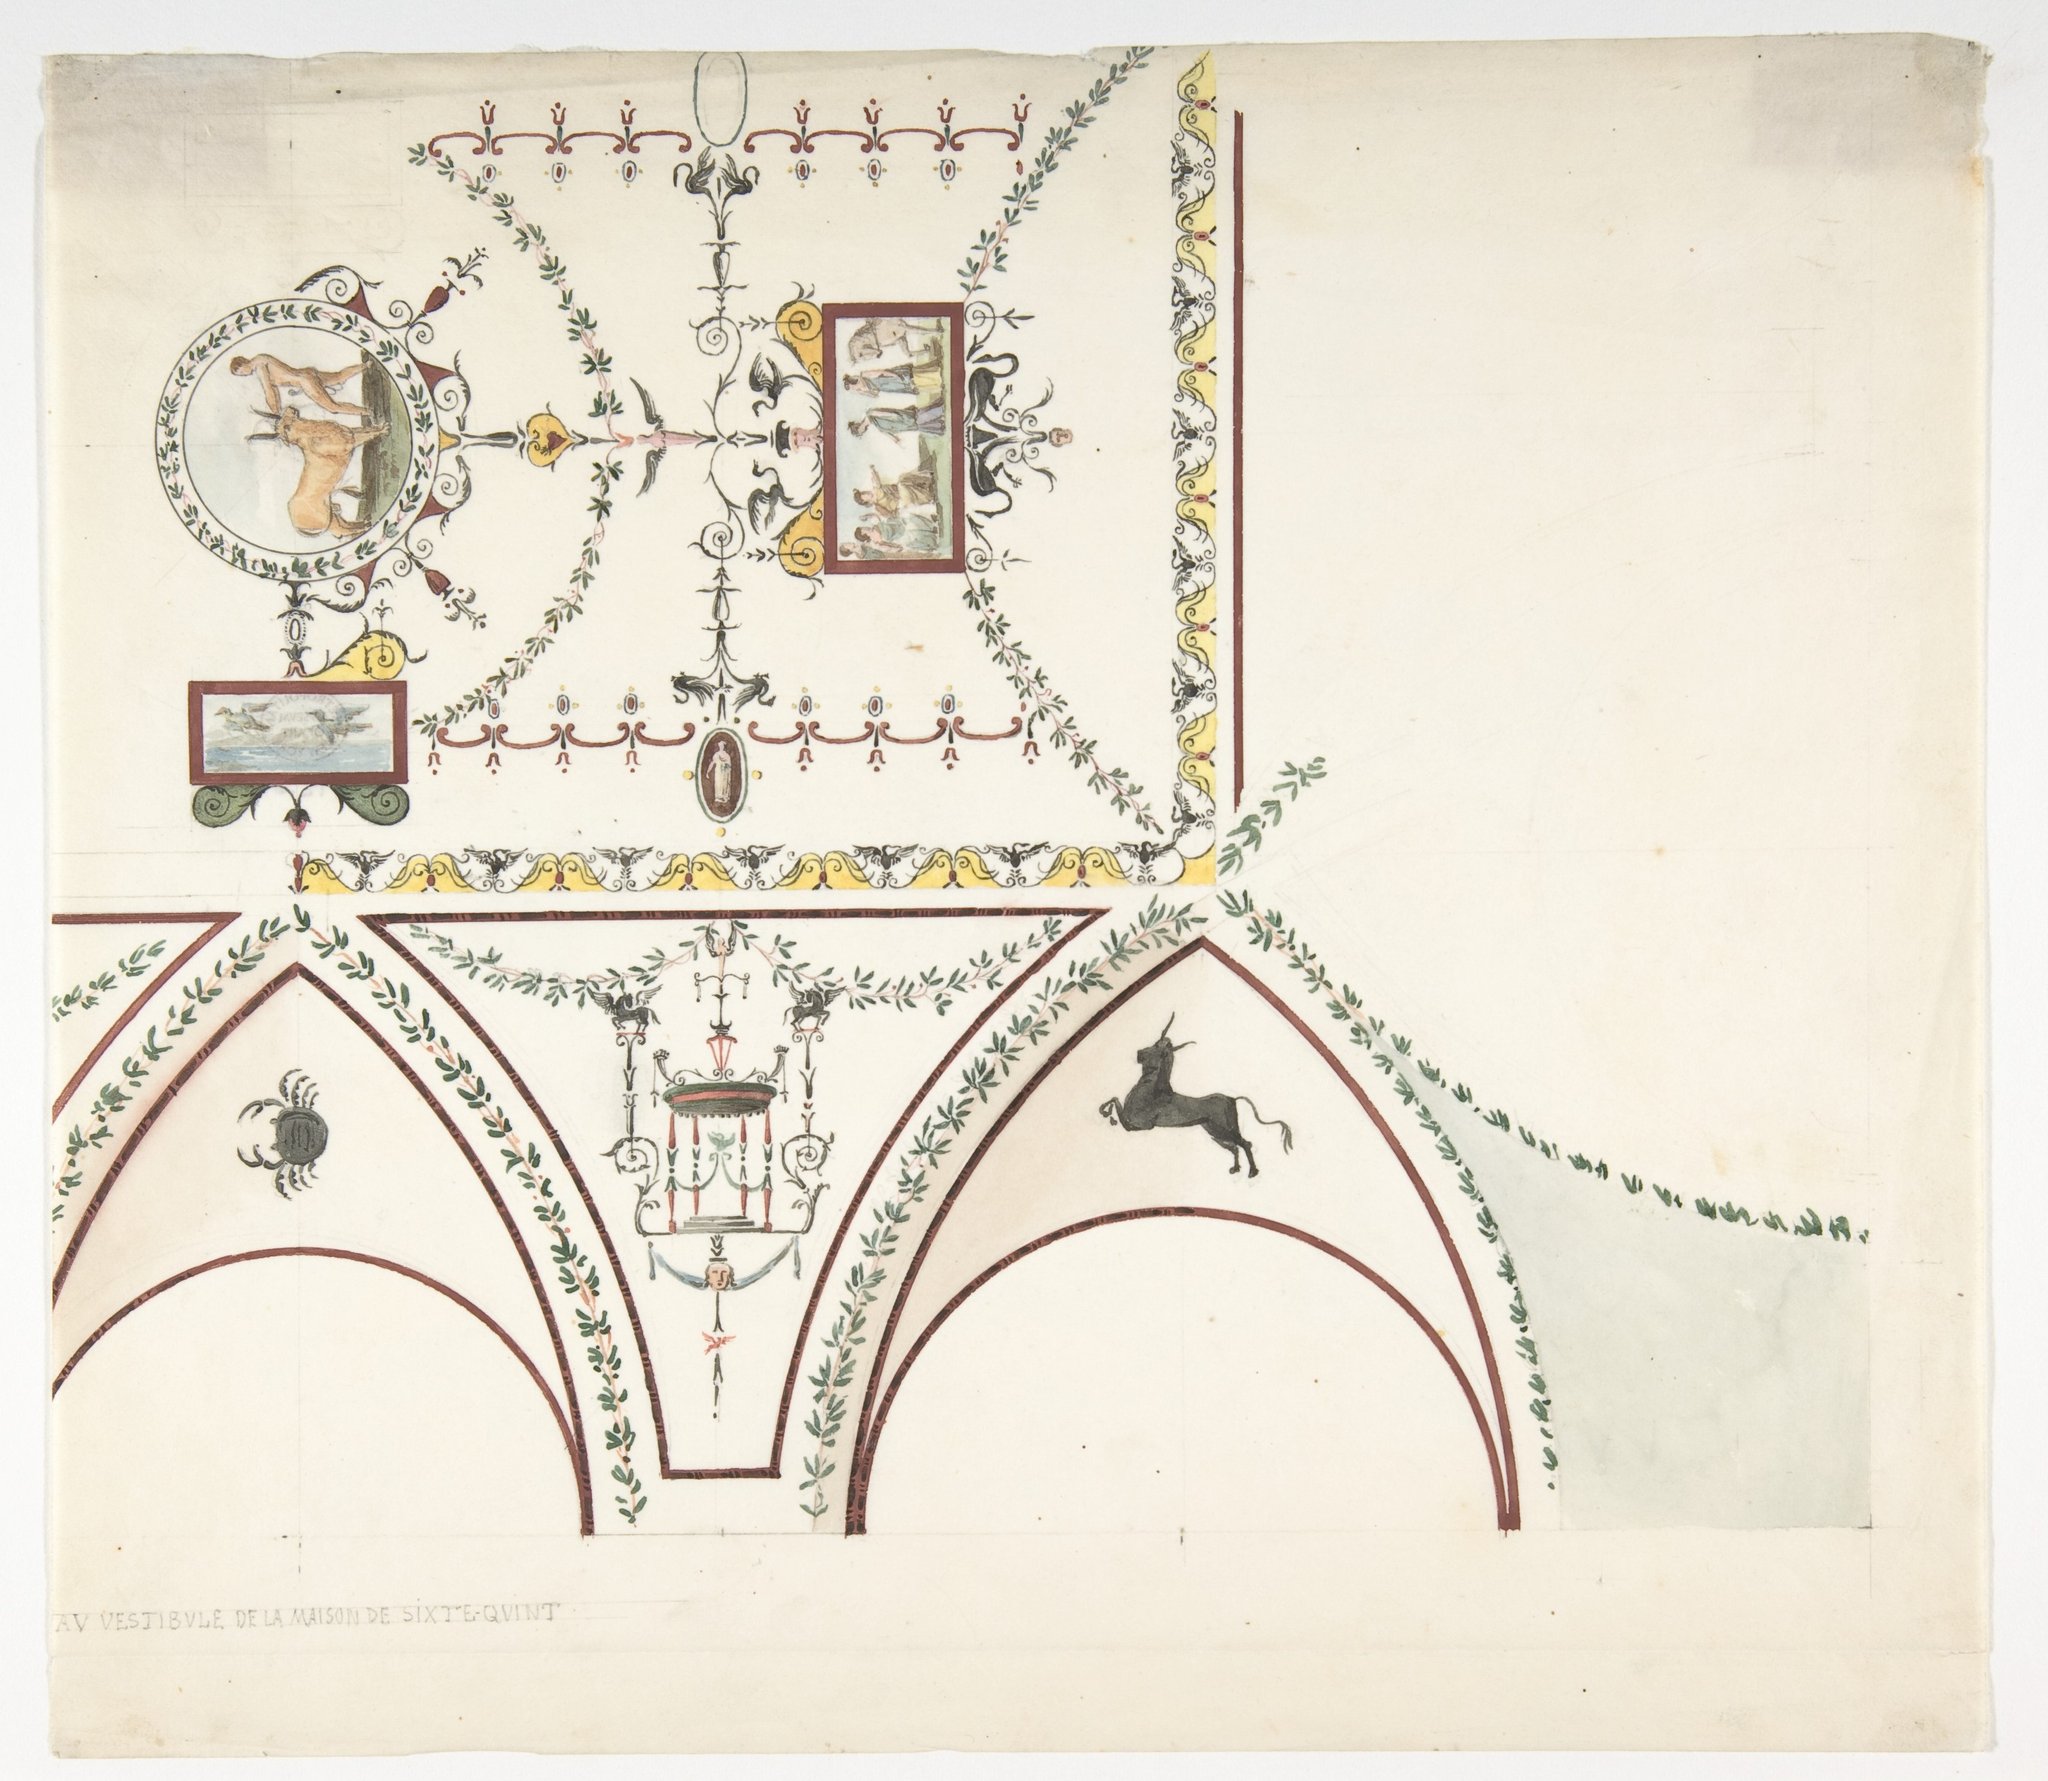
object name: drawing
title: Design for a Vestibule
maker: anonymous, french, 19th century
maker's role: artist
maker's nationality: french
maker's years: 1800-1900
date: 1801-1900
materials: graphite, ink, watercolor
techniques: pen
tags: birds,male nudes,women,pegasus,horses